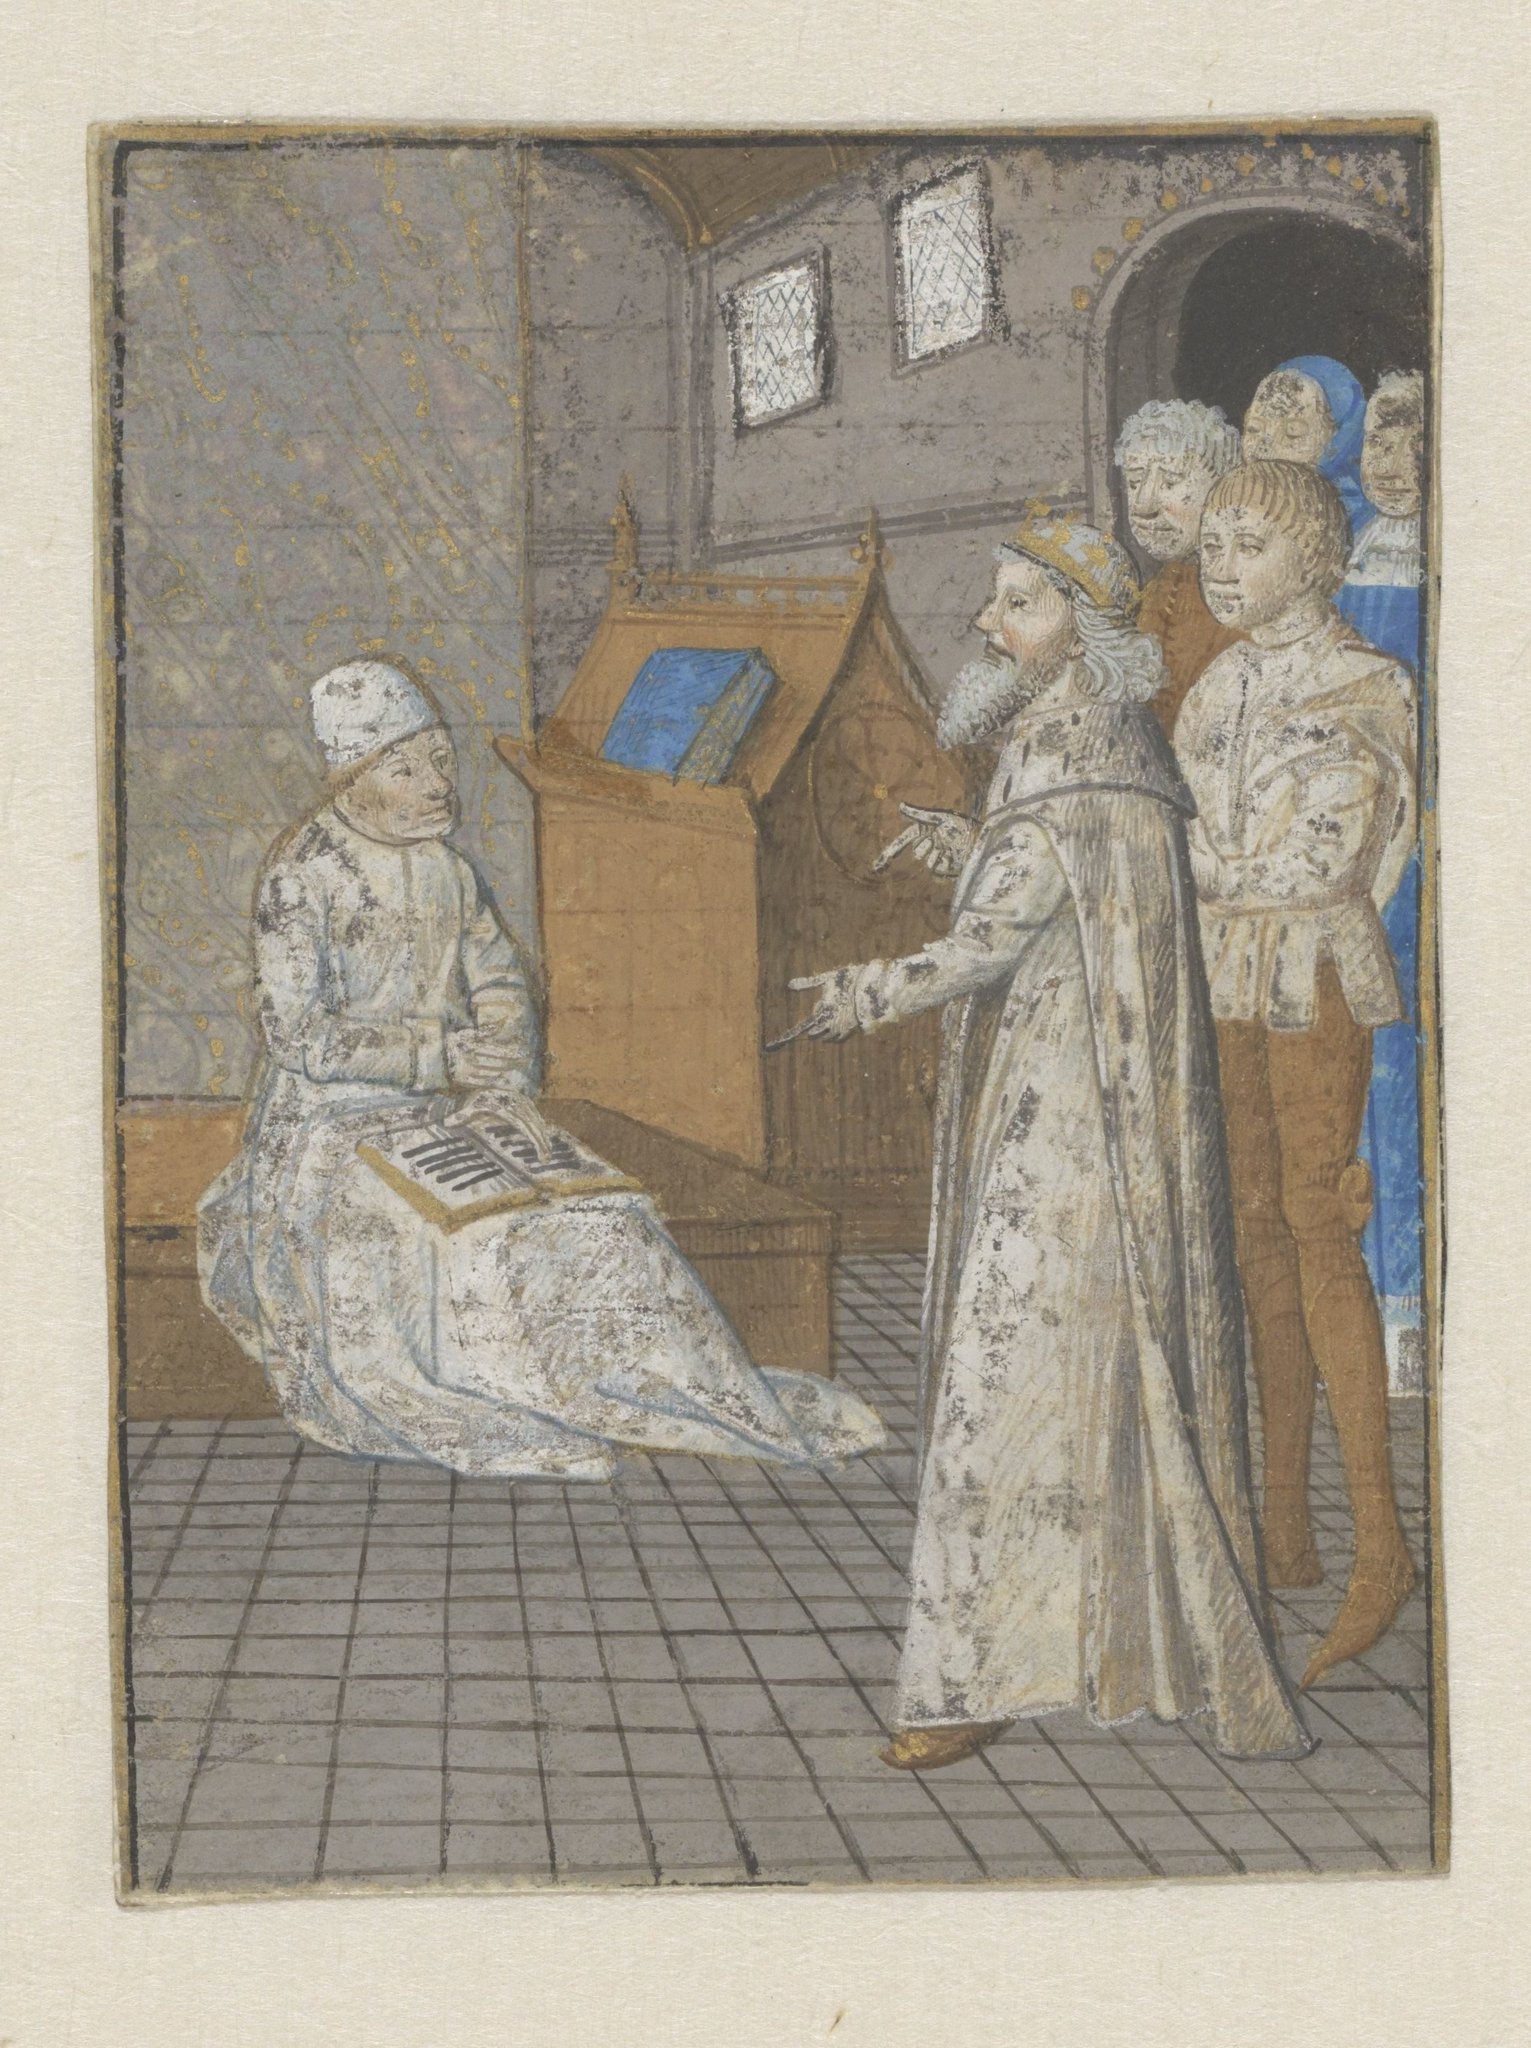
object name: miniature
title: De lotgevallen van edele mannen en vrouwen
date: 1470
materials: paint, parchment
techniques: brush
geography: loire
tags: giovanni boccaccio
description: De lotgevallen van edele mannen en vrouwen: een koning vertelt zijn verhaal aan de links gezeten Boccacio. Gebaseerd op Boccacio's 'Des cas des nobles hommes et femmes' (De lotgevalen van edele mannen en vrouwen).